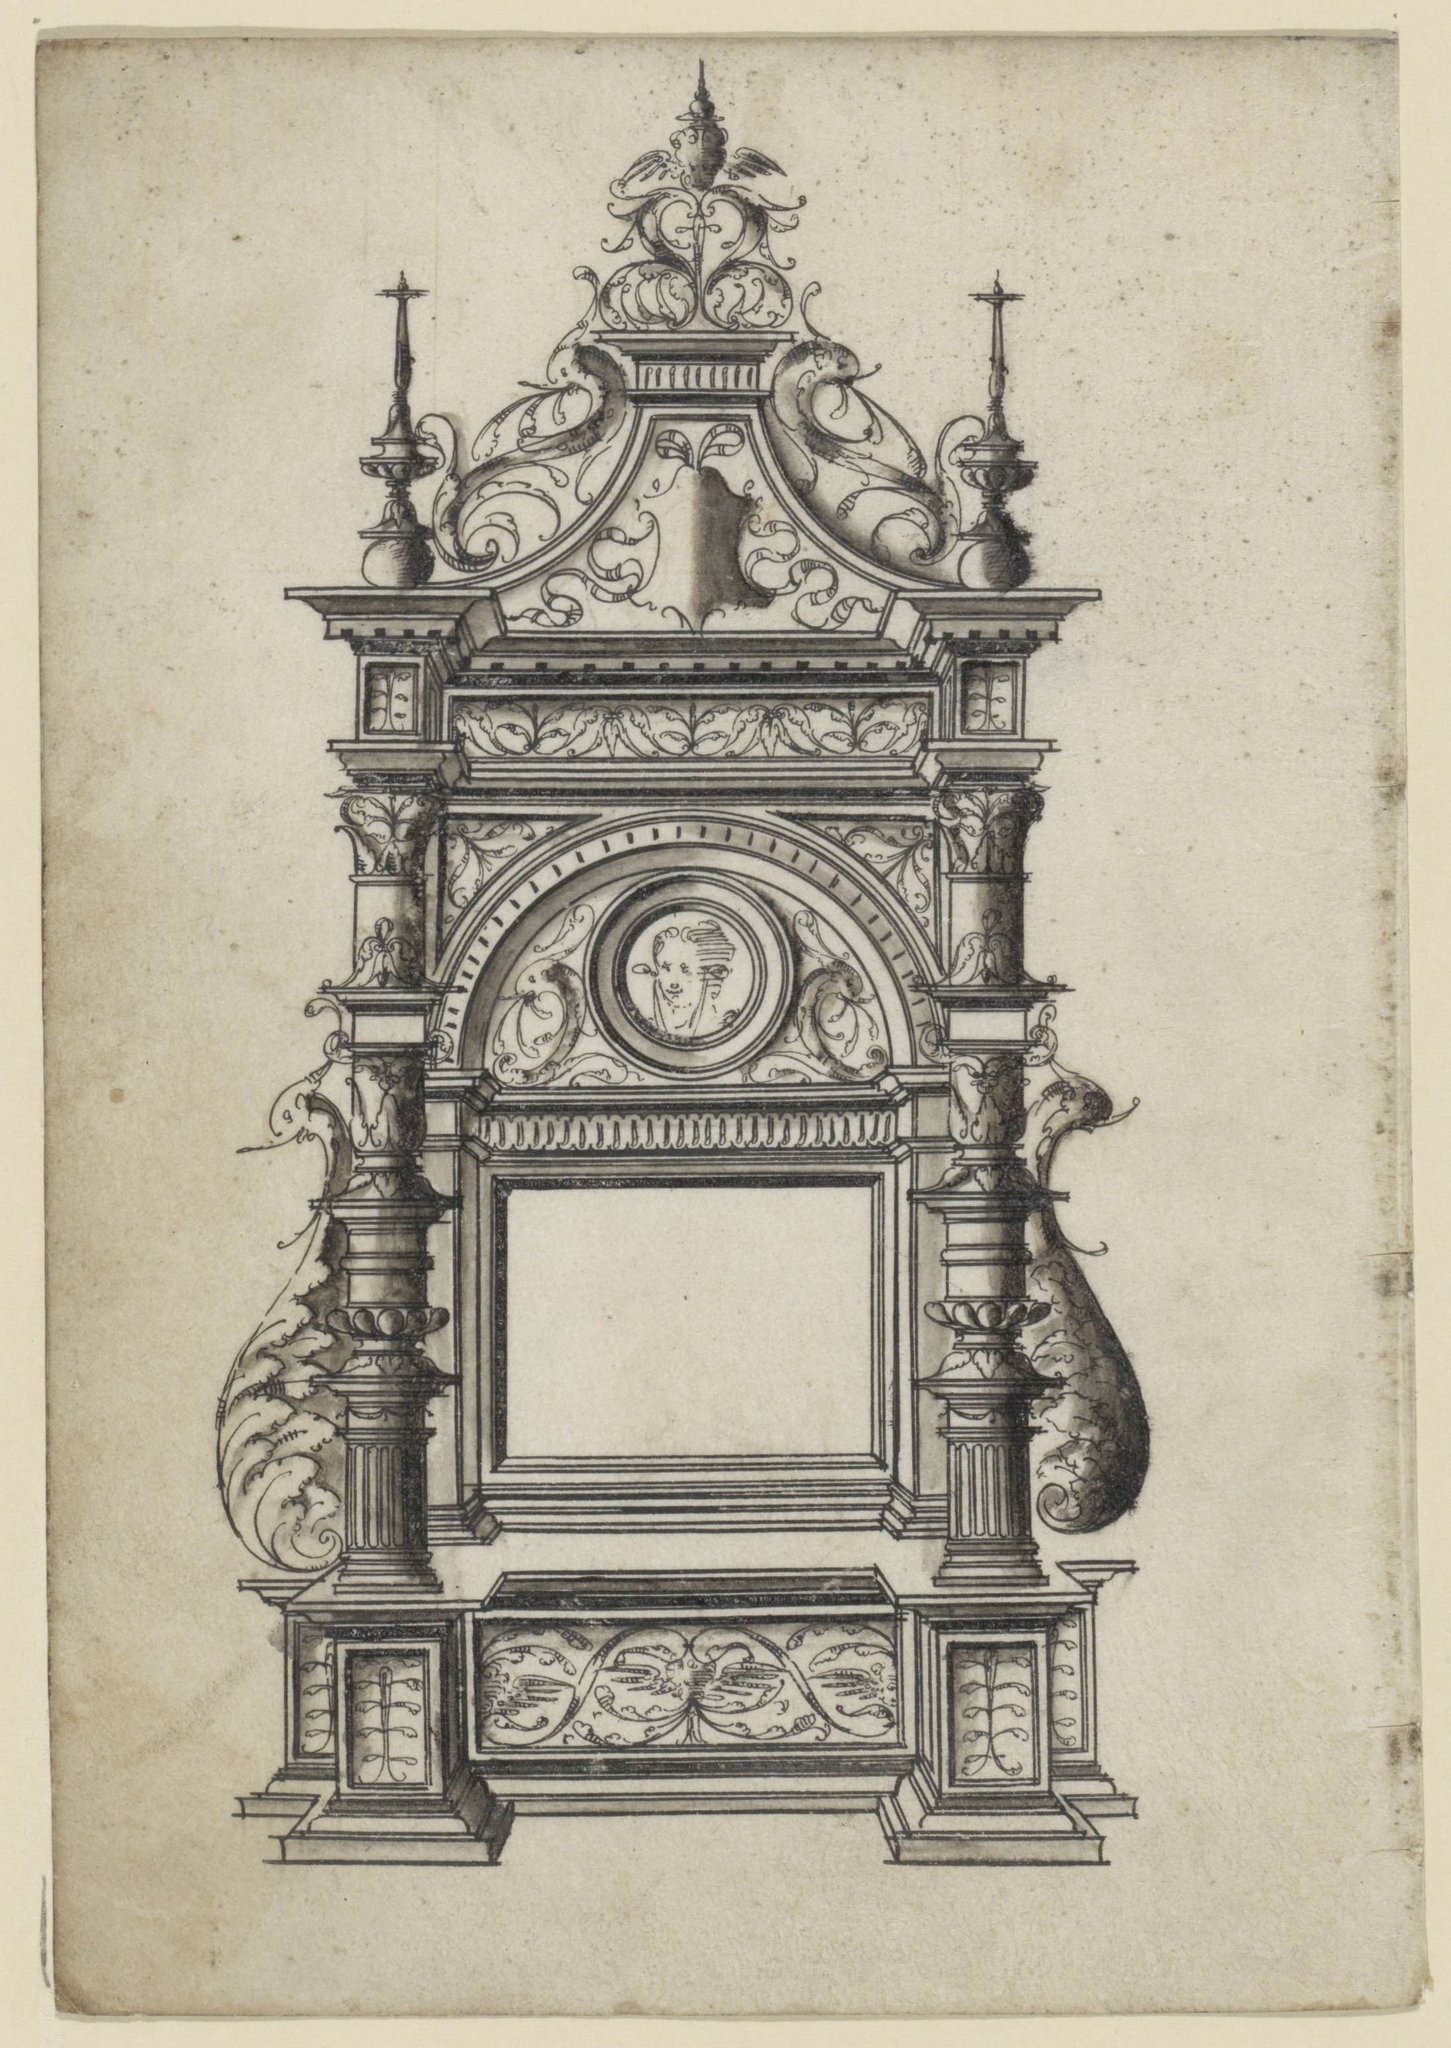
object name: album leaf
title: Retabel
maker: jacques androuet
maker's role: draughtsman, print maker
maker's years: 1515-1584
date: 1543-1553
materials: ink, parchment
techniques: brush, pen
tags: altar with dossel (dorsal), 'reredos', altar-screen, retable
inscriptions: number: ‘14’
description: Blad 14 verso, los opgezet blad uit een album bestaande uit een band met twee bladen, een schutblad en zeventien apart opgezette bladen.